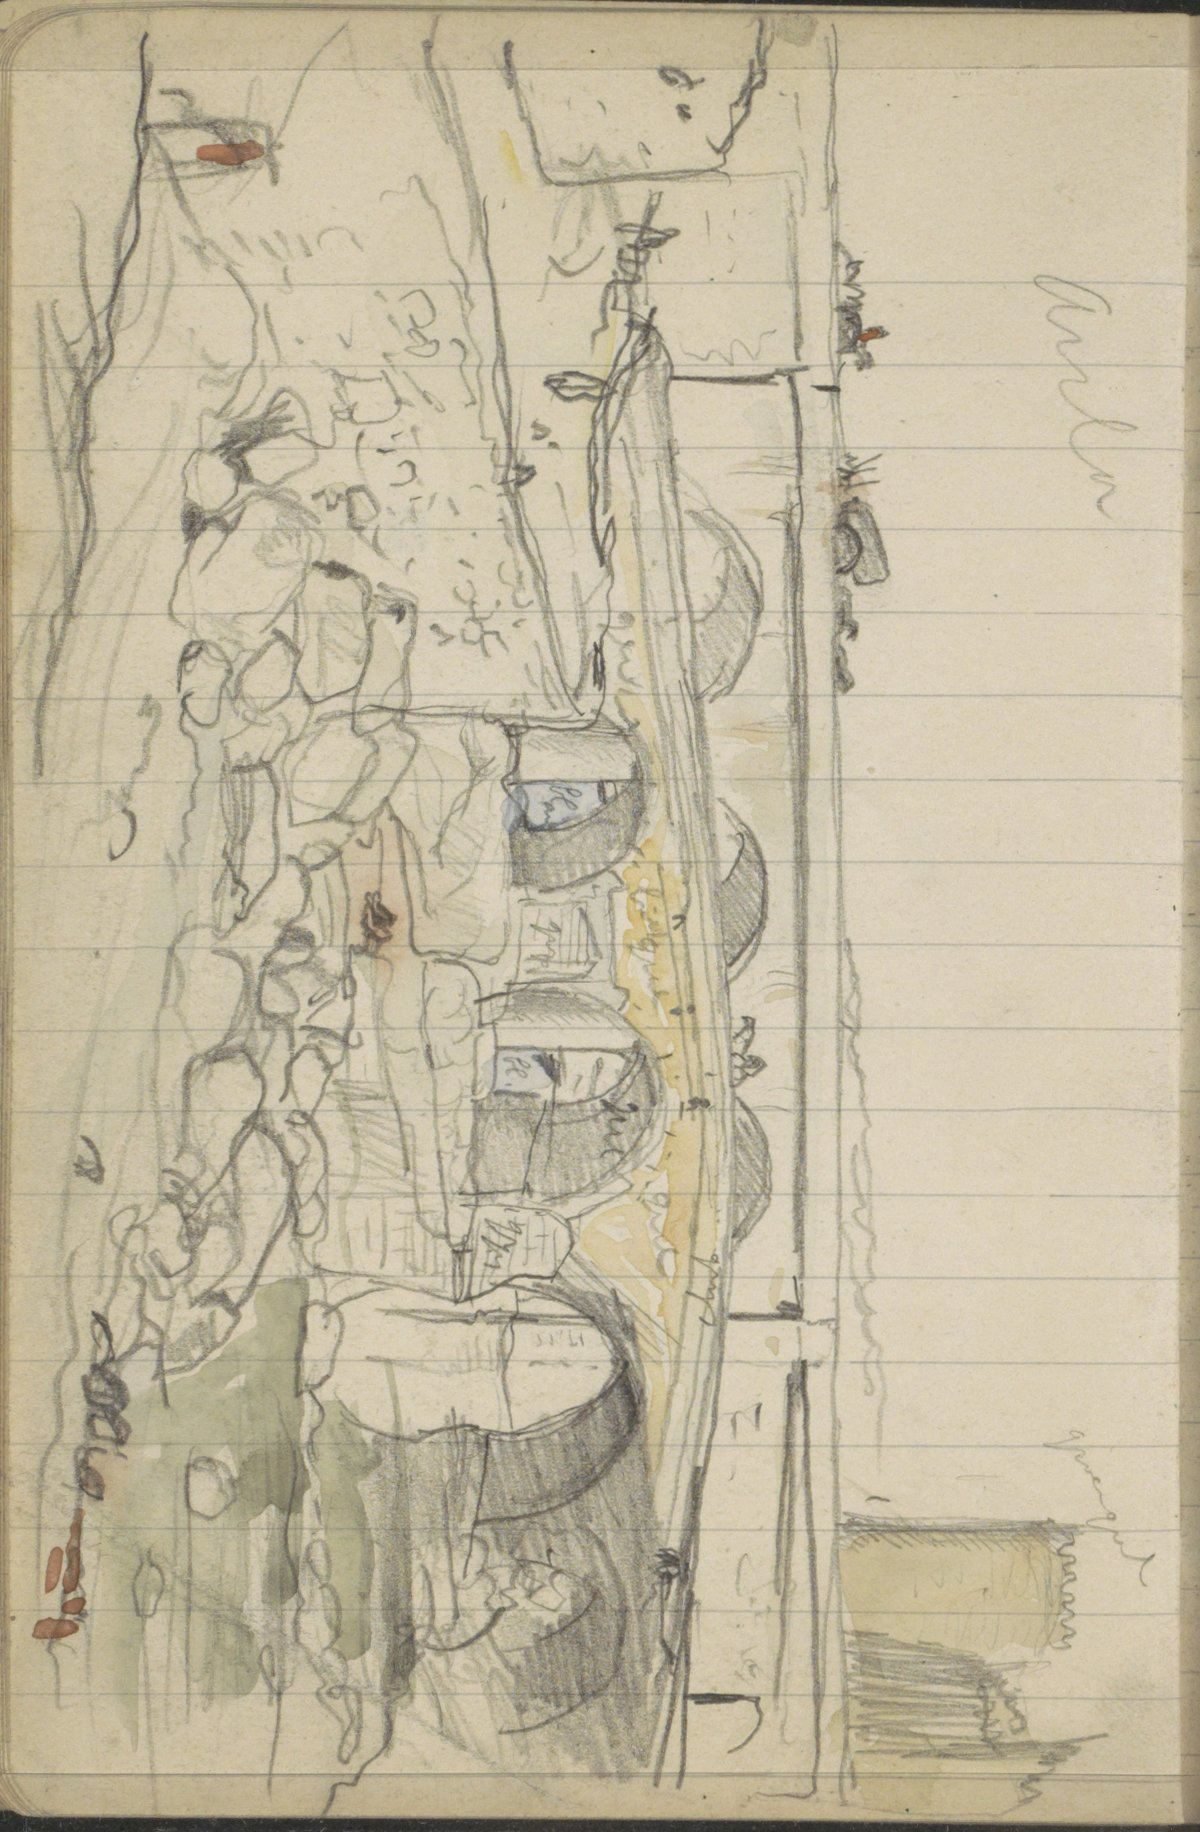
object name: sketchbook leaf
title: Gezicht op de brug naar Ávila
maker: marius bauer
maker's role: draughtsman, print maker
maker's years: 1867-1932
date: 1902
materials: pencil, watercolor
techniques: brush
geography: avila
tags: city-view, and landscape with man-made constructions, bridge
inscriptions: annotation: ‘Avila’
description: Pagina 66 uit een schetsboek met 50 bladen.